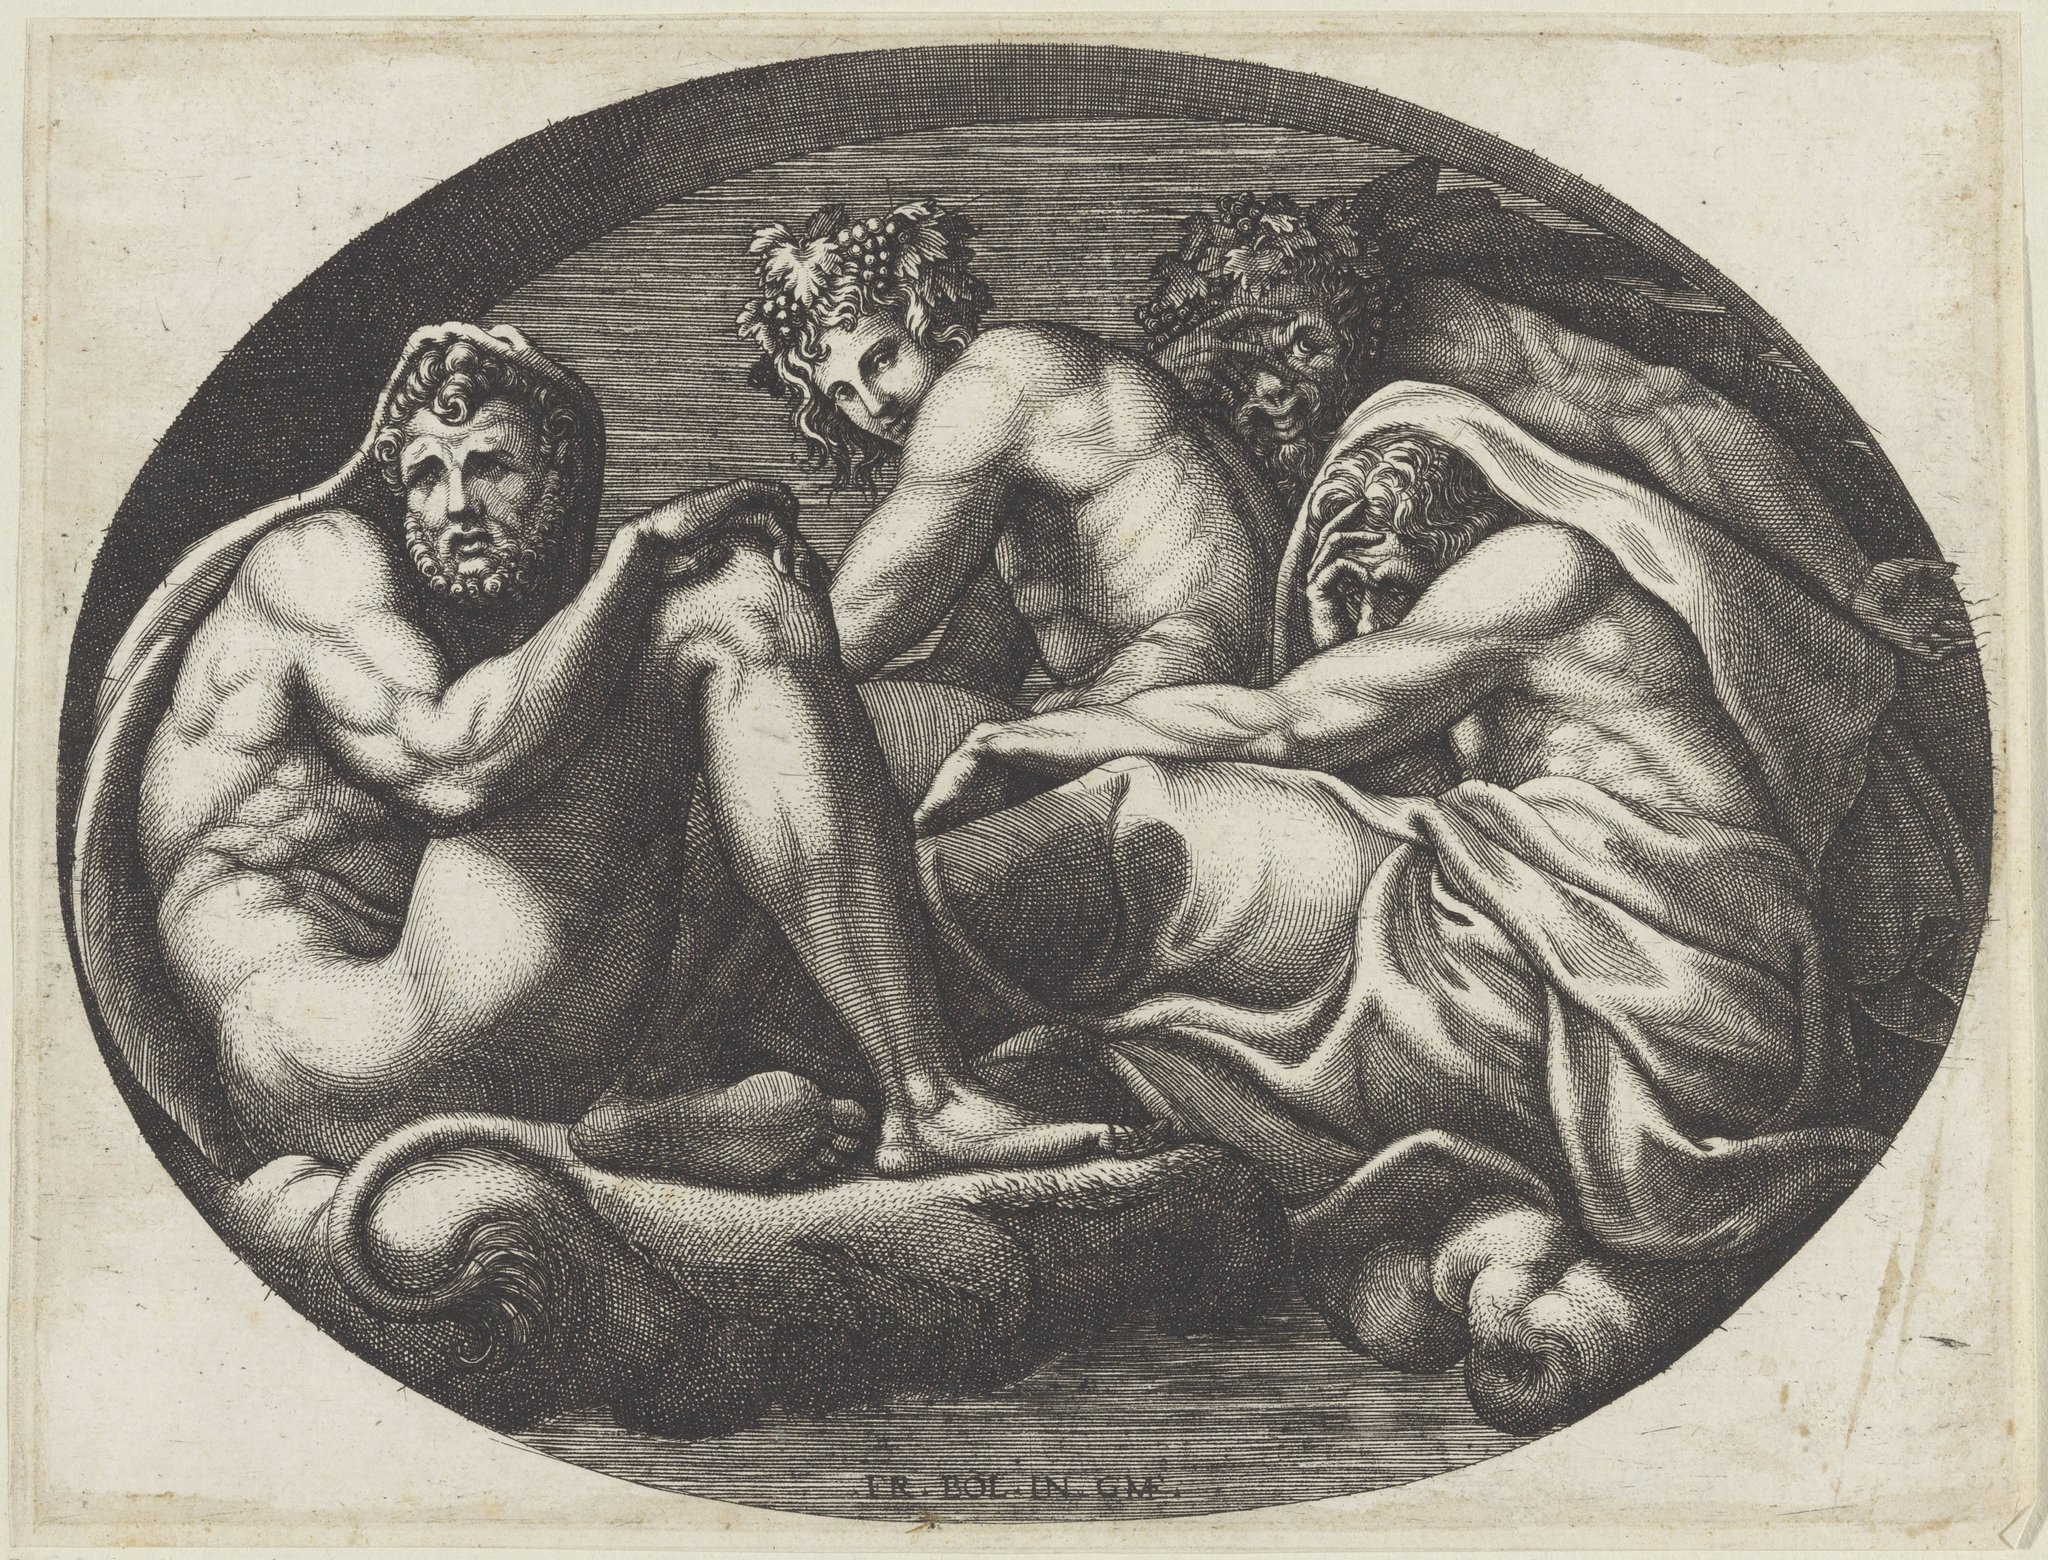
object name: print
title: Ovale plafondschilderingen in de Galerie d'Ulysse te Fontainebleau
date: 1541-1582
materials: paper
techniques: engraving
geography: italy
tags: (story of) hercules (heracles), (story of) bacchus (dionysus), liber, (story of) pan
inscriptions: collector's mark: Lugt 240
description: Prent uit een reeks van vier prenten naar plafondschilderingen in de Galerie d'Ulysse te Fontainebleau, door Francesco Primaticcio.